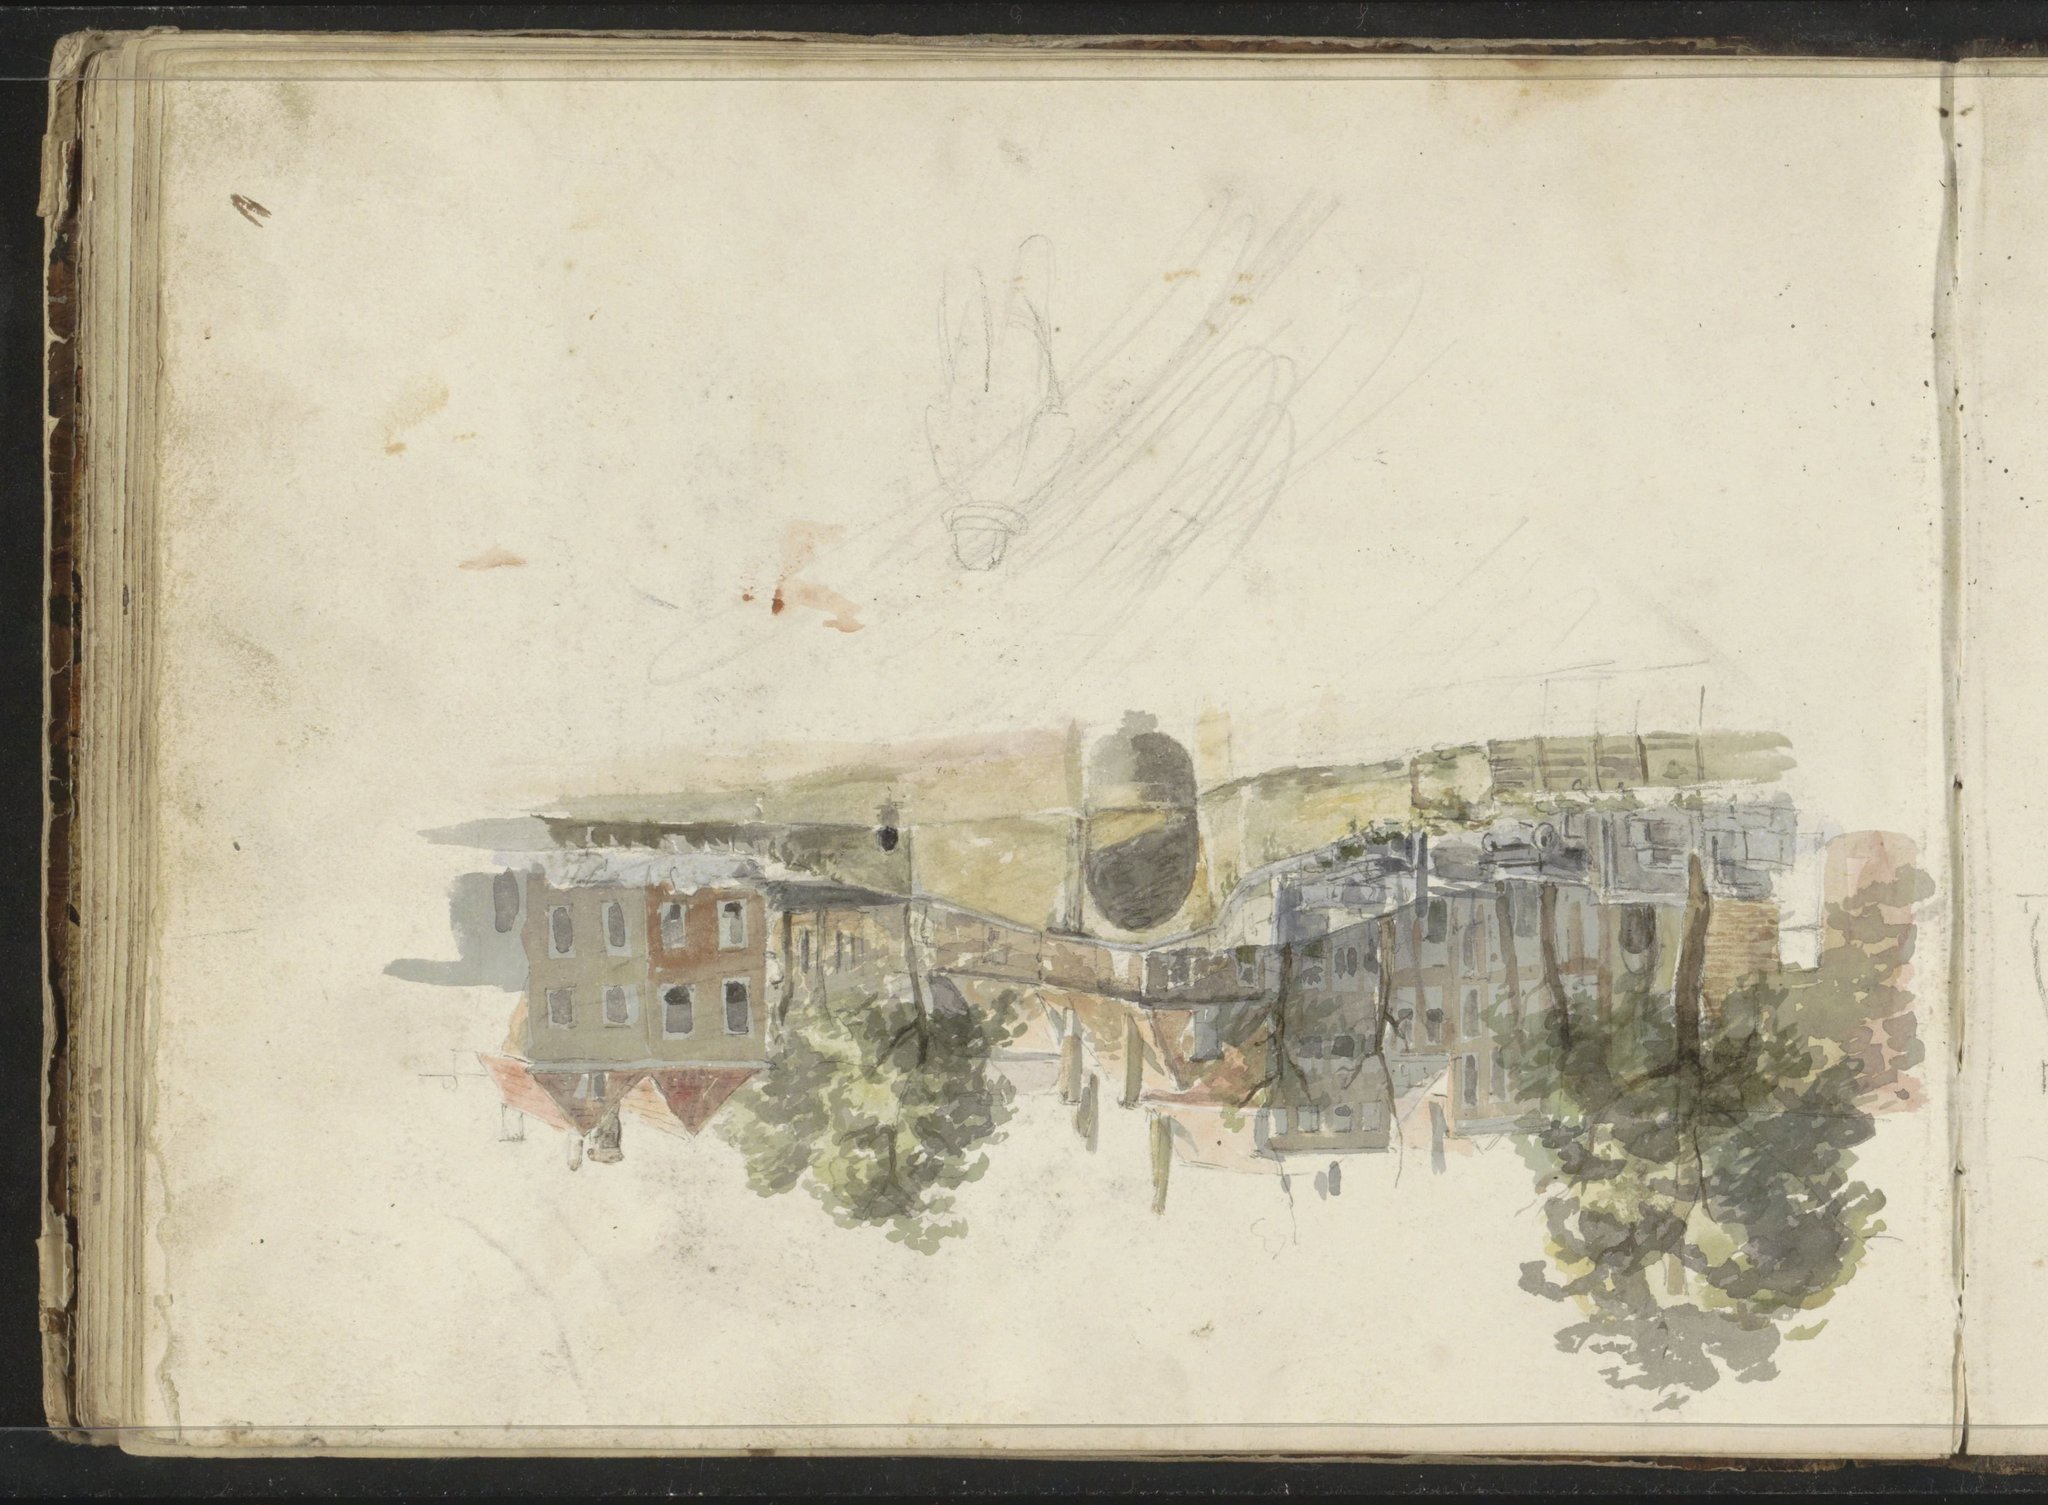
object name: sketchbook leaf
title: Stadsgezicht met een brug over een gracht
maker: willem troost (ii)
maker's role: draughtsman, painter, print maker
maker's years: 1812-1893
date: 1822-1893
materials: paper, pencil, watercolor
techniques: brush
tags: city-view, and landscape with man-made constructions, canals, waters (in city)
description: Tevens een studie van een man met een bolhoed. Blad 54 verso uit een schetsboek met 36 bladen.